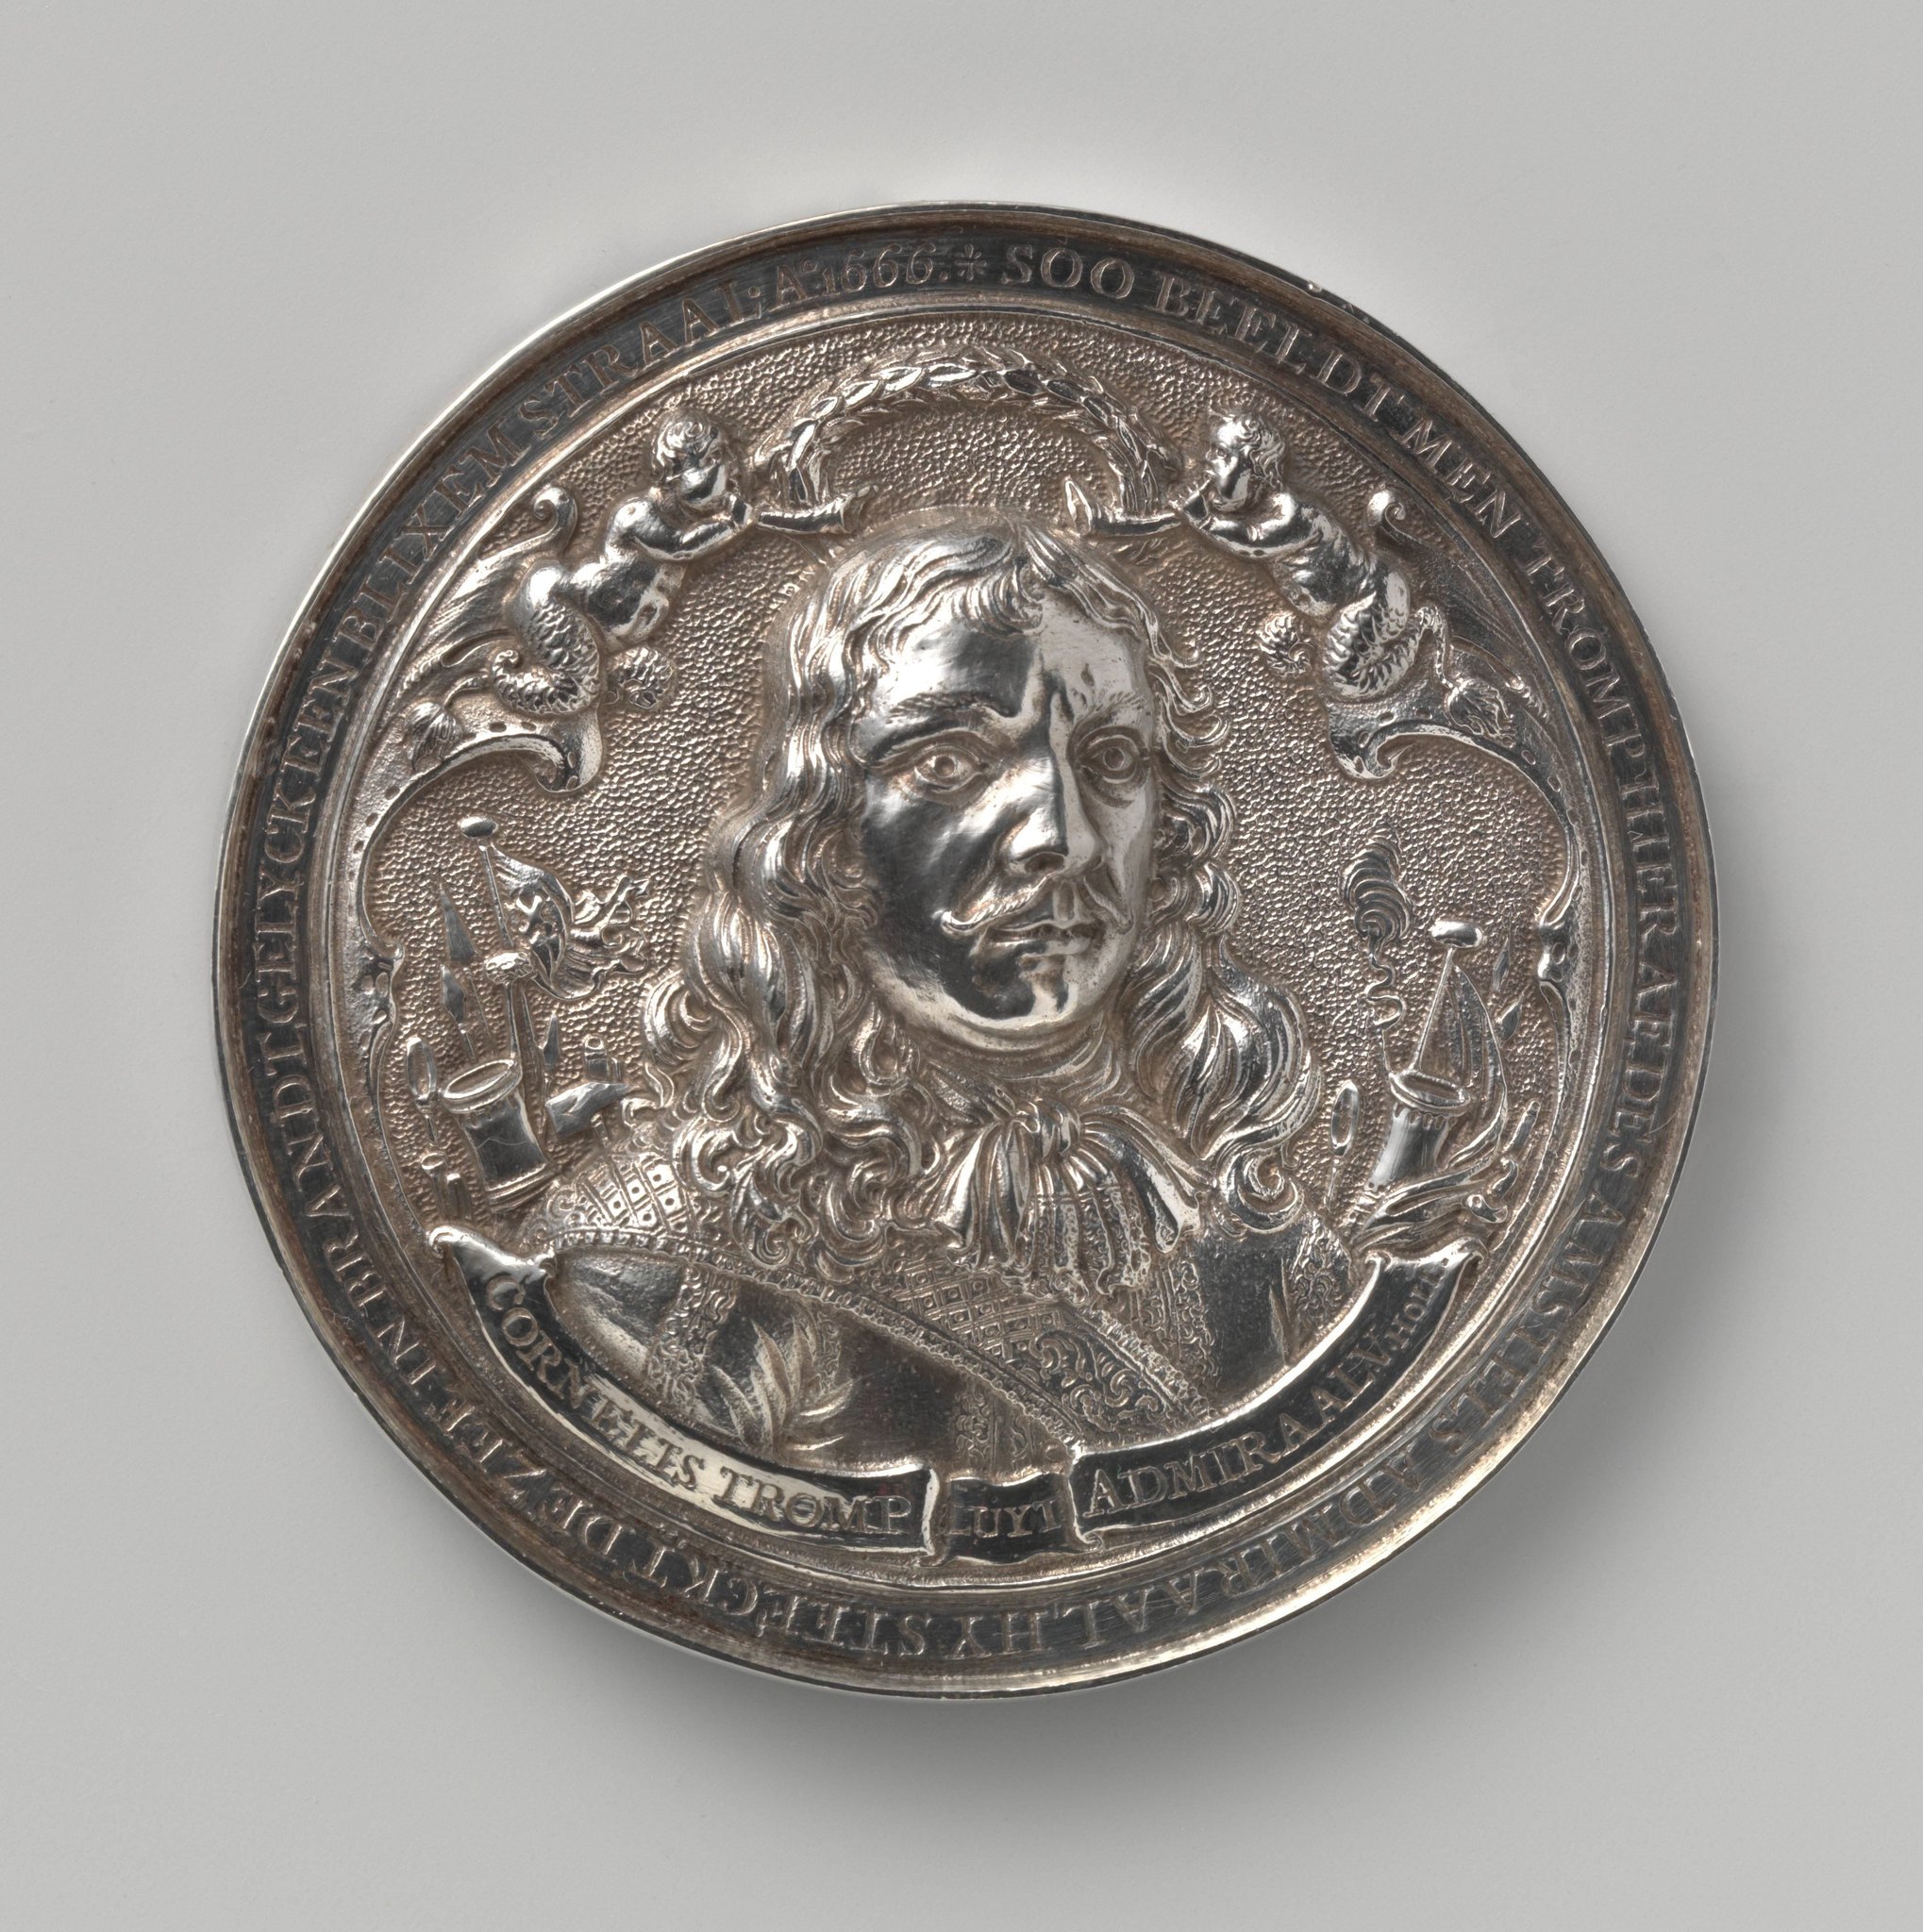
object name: history medal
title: Cornelis Tromp en ter herdenking van de Vierdaagse Zeeslag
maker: wouter muller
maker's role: publisher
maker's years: 1604-1673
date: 1666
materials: silver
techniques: casting, engraving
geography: amsterdam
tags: cornelis tromp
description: Zilveren penning. Voorzijde: borststuk man waarboven twee tritons lauwerkrans houden te midden van wapentuig, daaronder banderol met opschrift binnen omschrift. Keerzijde: zeeslag binnen omschrift.